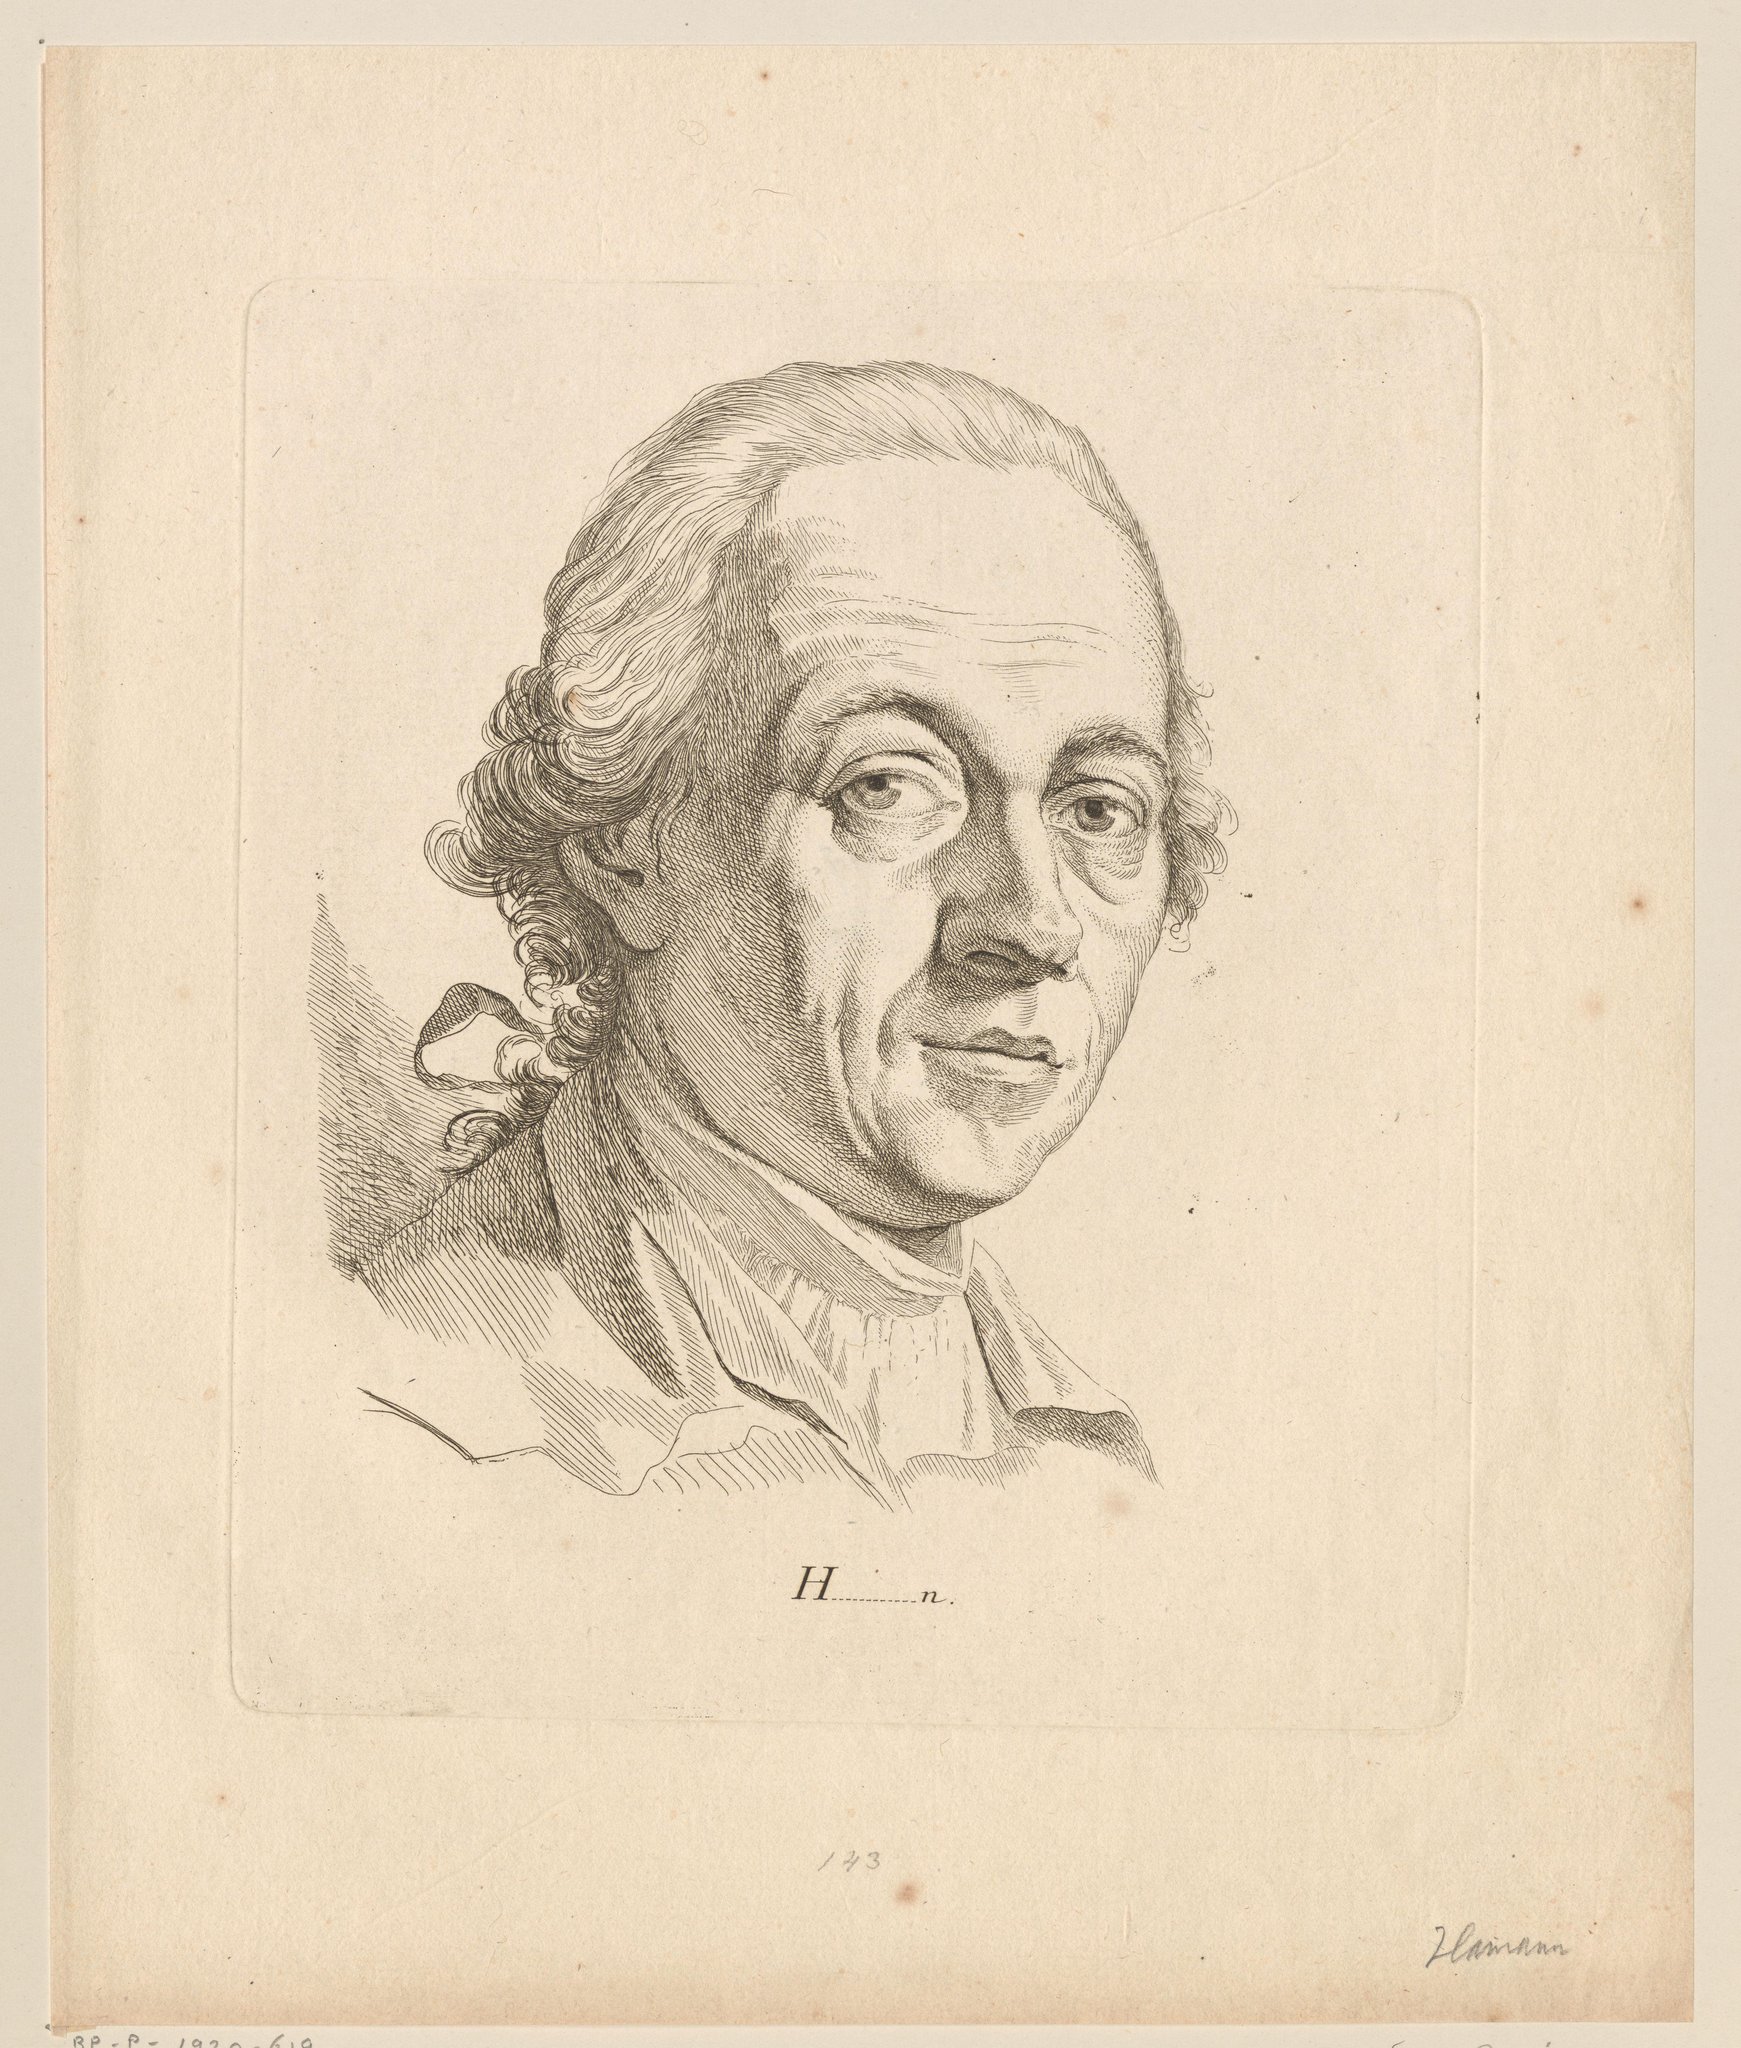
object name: print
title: Portret van een man, mogelijk Johann Georg Hamann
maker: Anonymous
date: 1750-1799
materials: paper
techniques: etching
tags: scholar, philosopher, historical persons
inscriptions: collector's mark: Lugt 2228